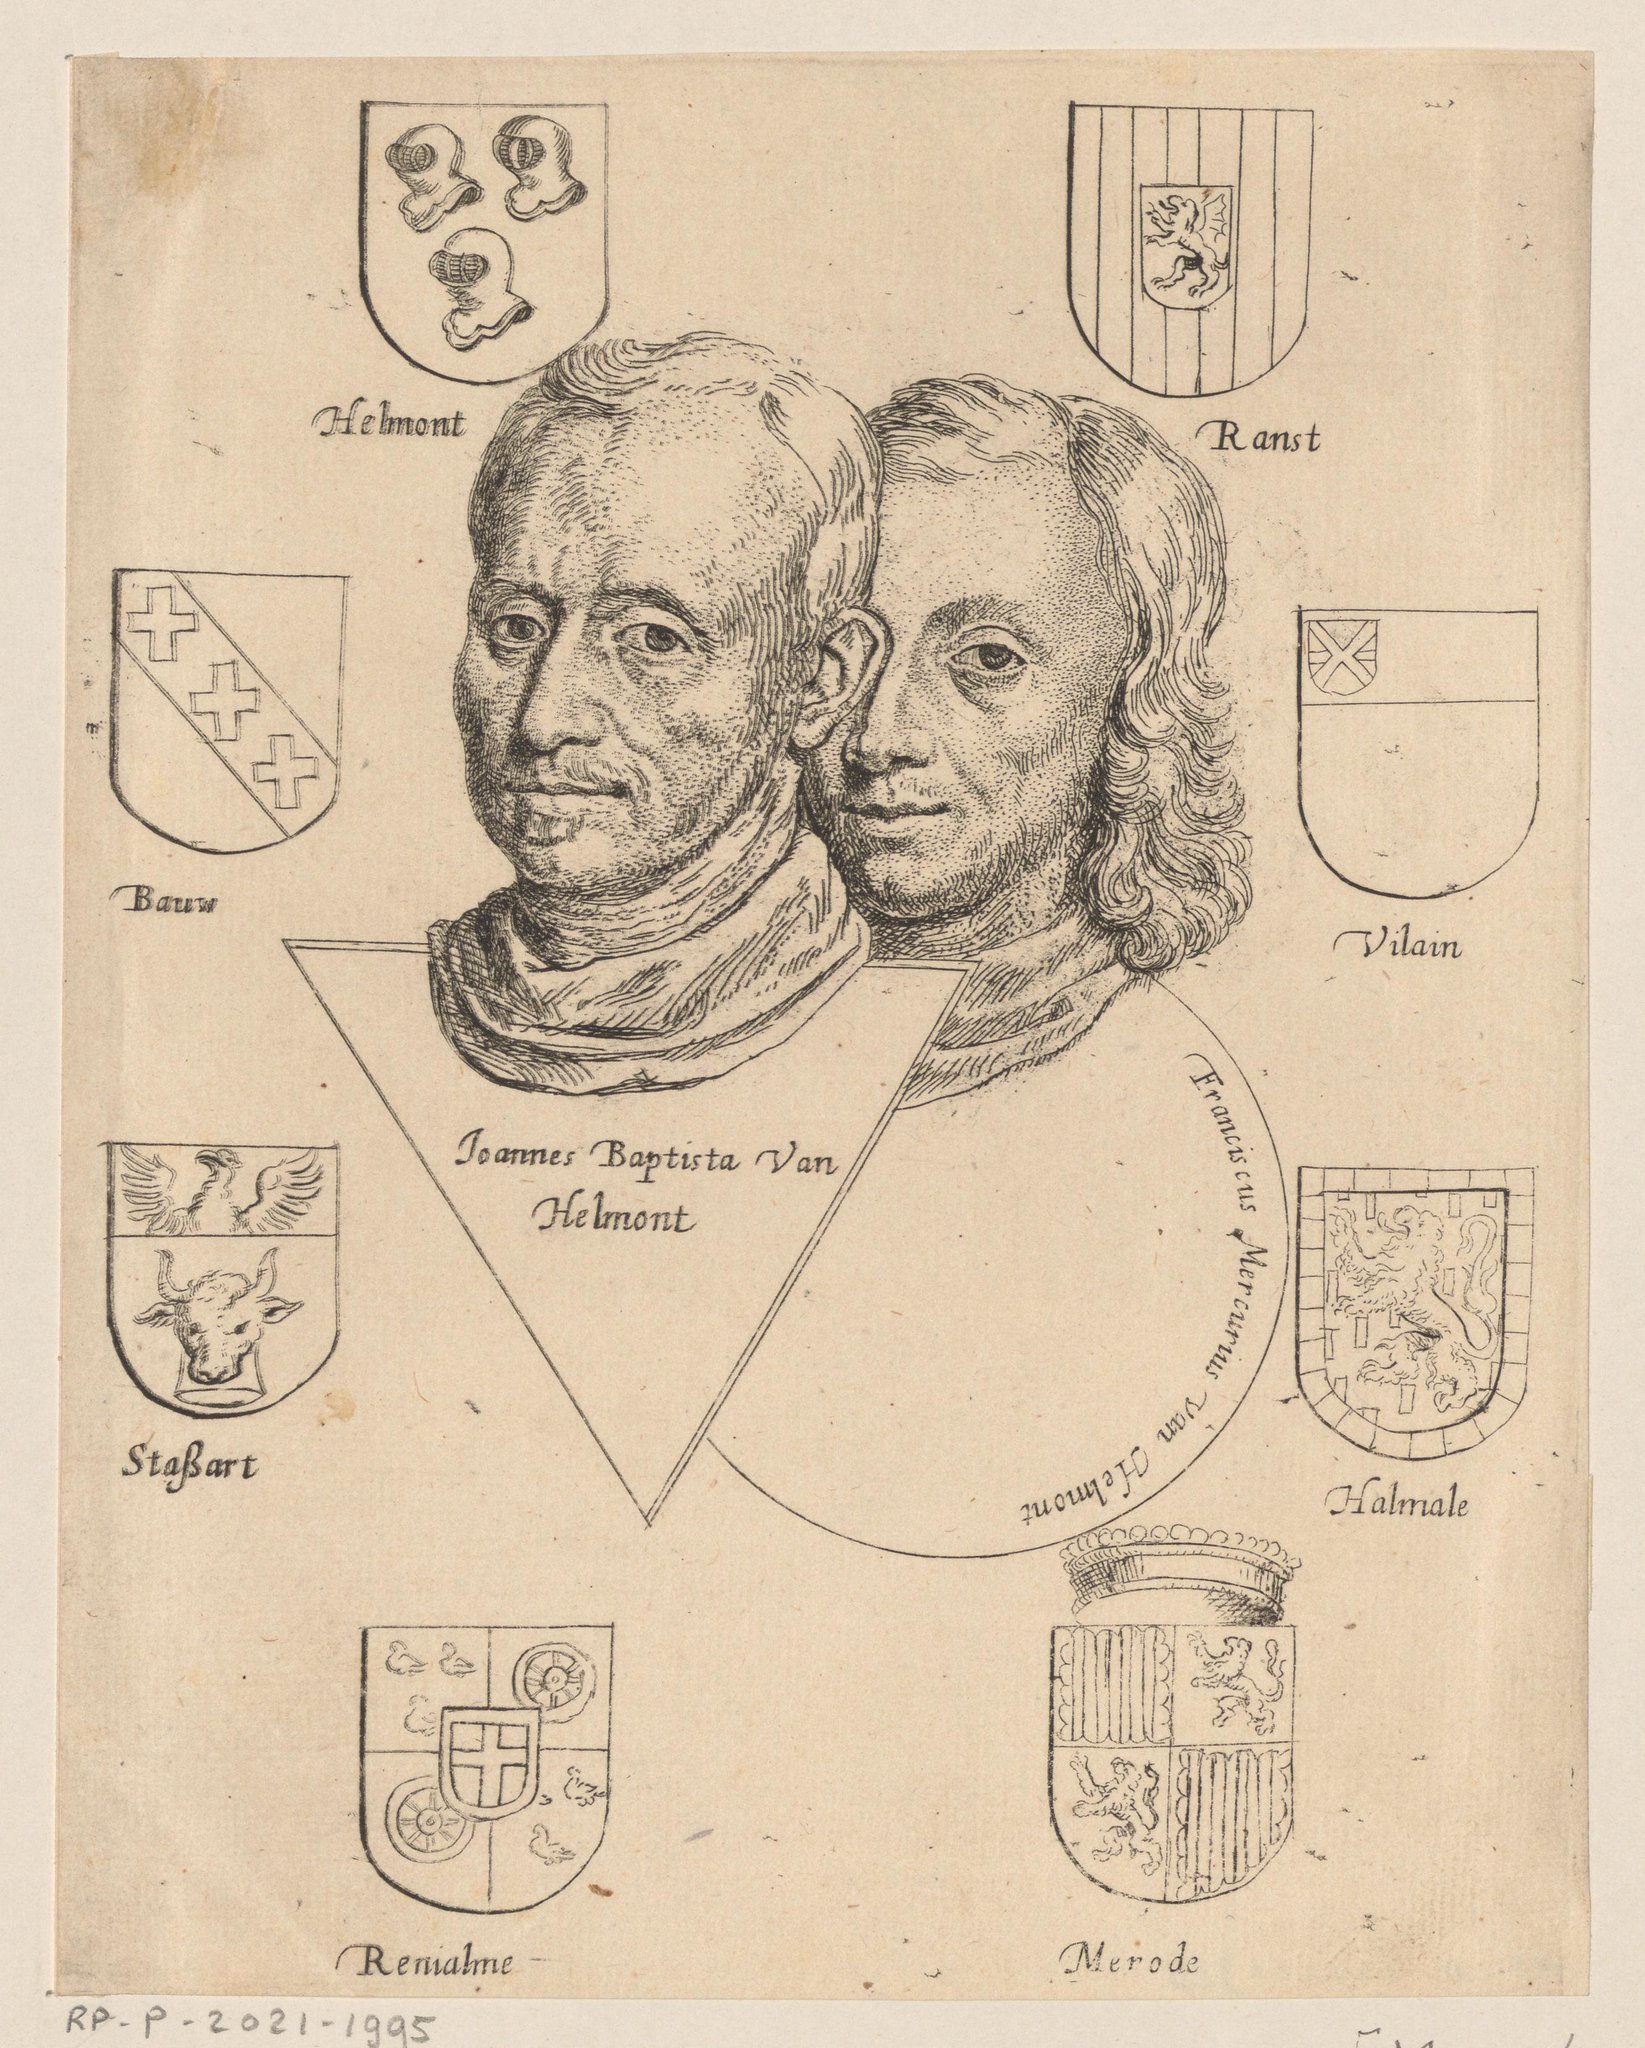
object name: print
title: Portretten van Jan Baptiste en Franciscus Mercurius van Helmont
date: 1648-1652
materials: paper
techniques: engraving, etching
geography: amsterdam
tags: brussels, berlin, historical persons, physician, doctor, armorial bearing, heraldry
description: Prent voor het eerst gebruikt in: Helmont, Jan Baptiste van. Ortus medicinae. Id est, initia physicae inaudita. Amsterdam: Lowijs Elzevier (III), 1648. Prent ook gebruikt in de tweede editie van 1652.